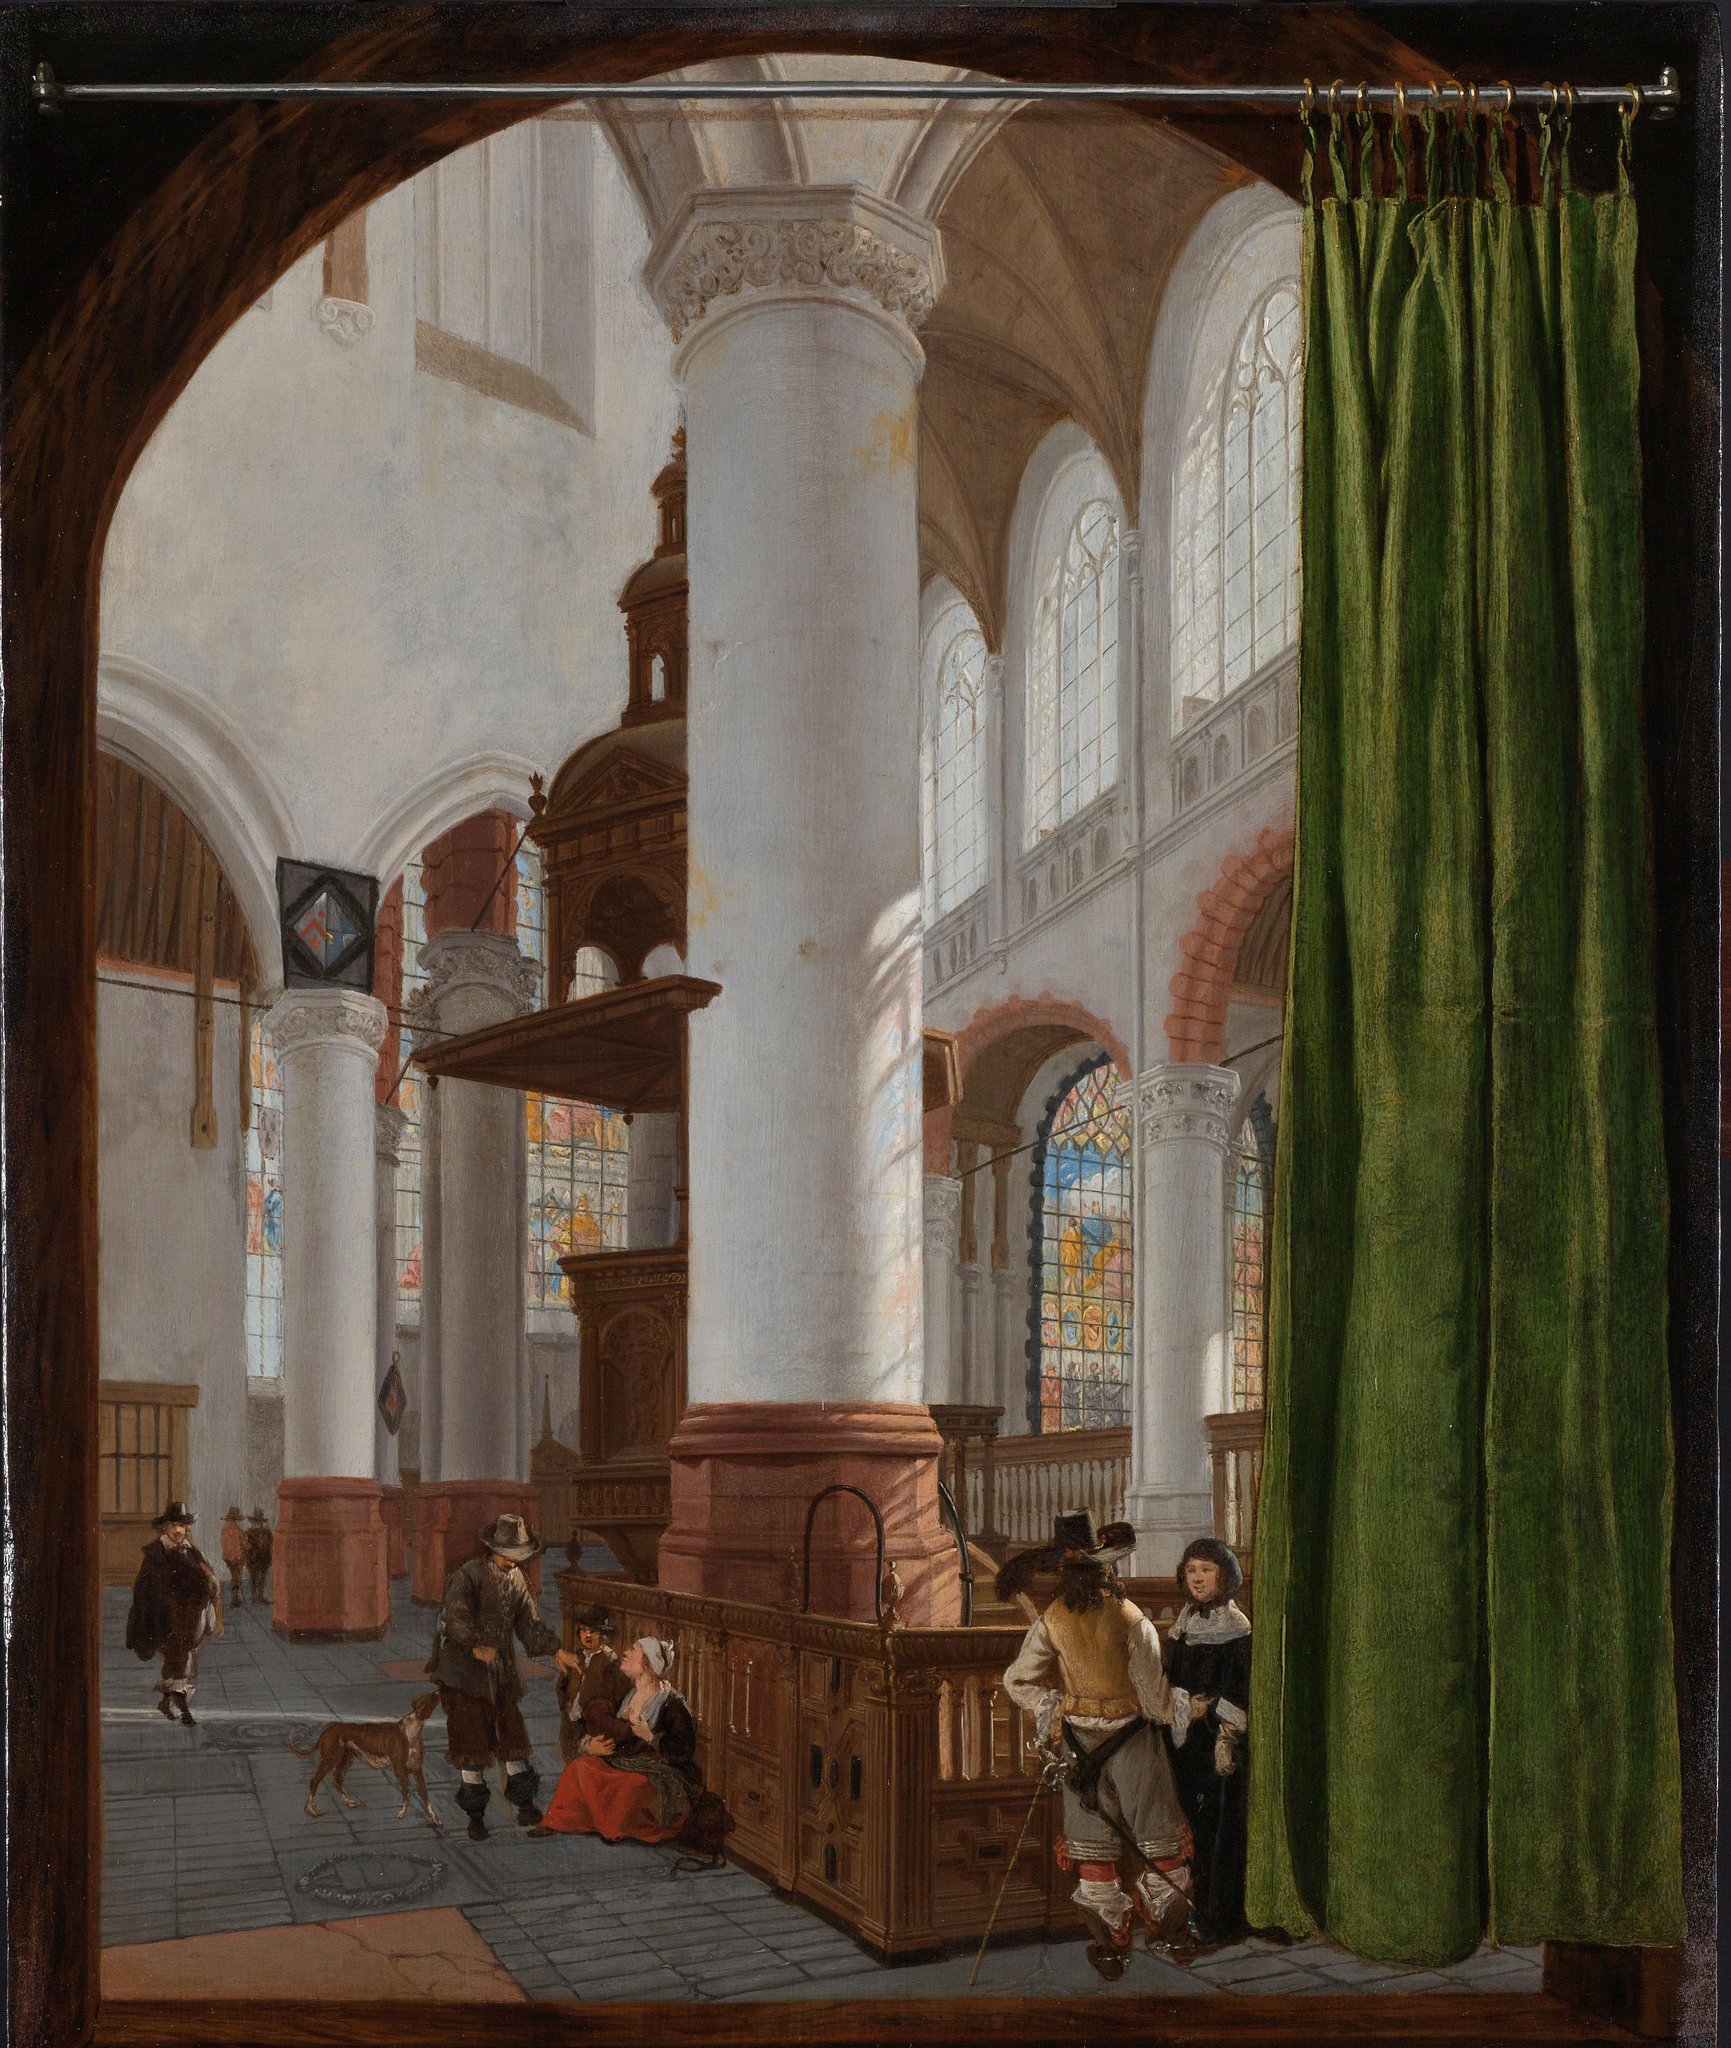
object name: painting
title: Interior of the Oude Kerk in Delft, with a Trompe l’Oeil Curtain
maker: gerard houckgeest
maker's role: painter, print maker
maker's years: 1600-1661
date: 1654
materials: oil, panel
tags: interior of church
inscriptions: signature and date, bottom centre: ‘GH•i654’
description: Gerrit Houckgeest specialized in church interiors and the use of perspective. With great attention to detail, he has here captured how the sunlight, pouring through the stained-glass windows, casts coloured dots on the column in the middle. The painted green curtain is a witty illusionistic device, imitating the 17th-century custom of protecting paintings from light and dust with a curtain.